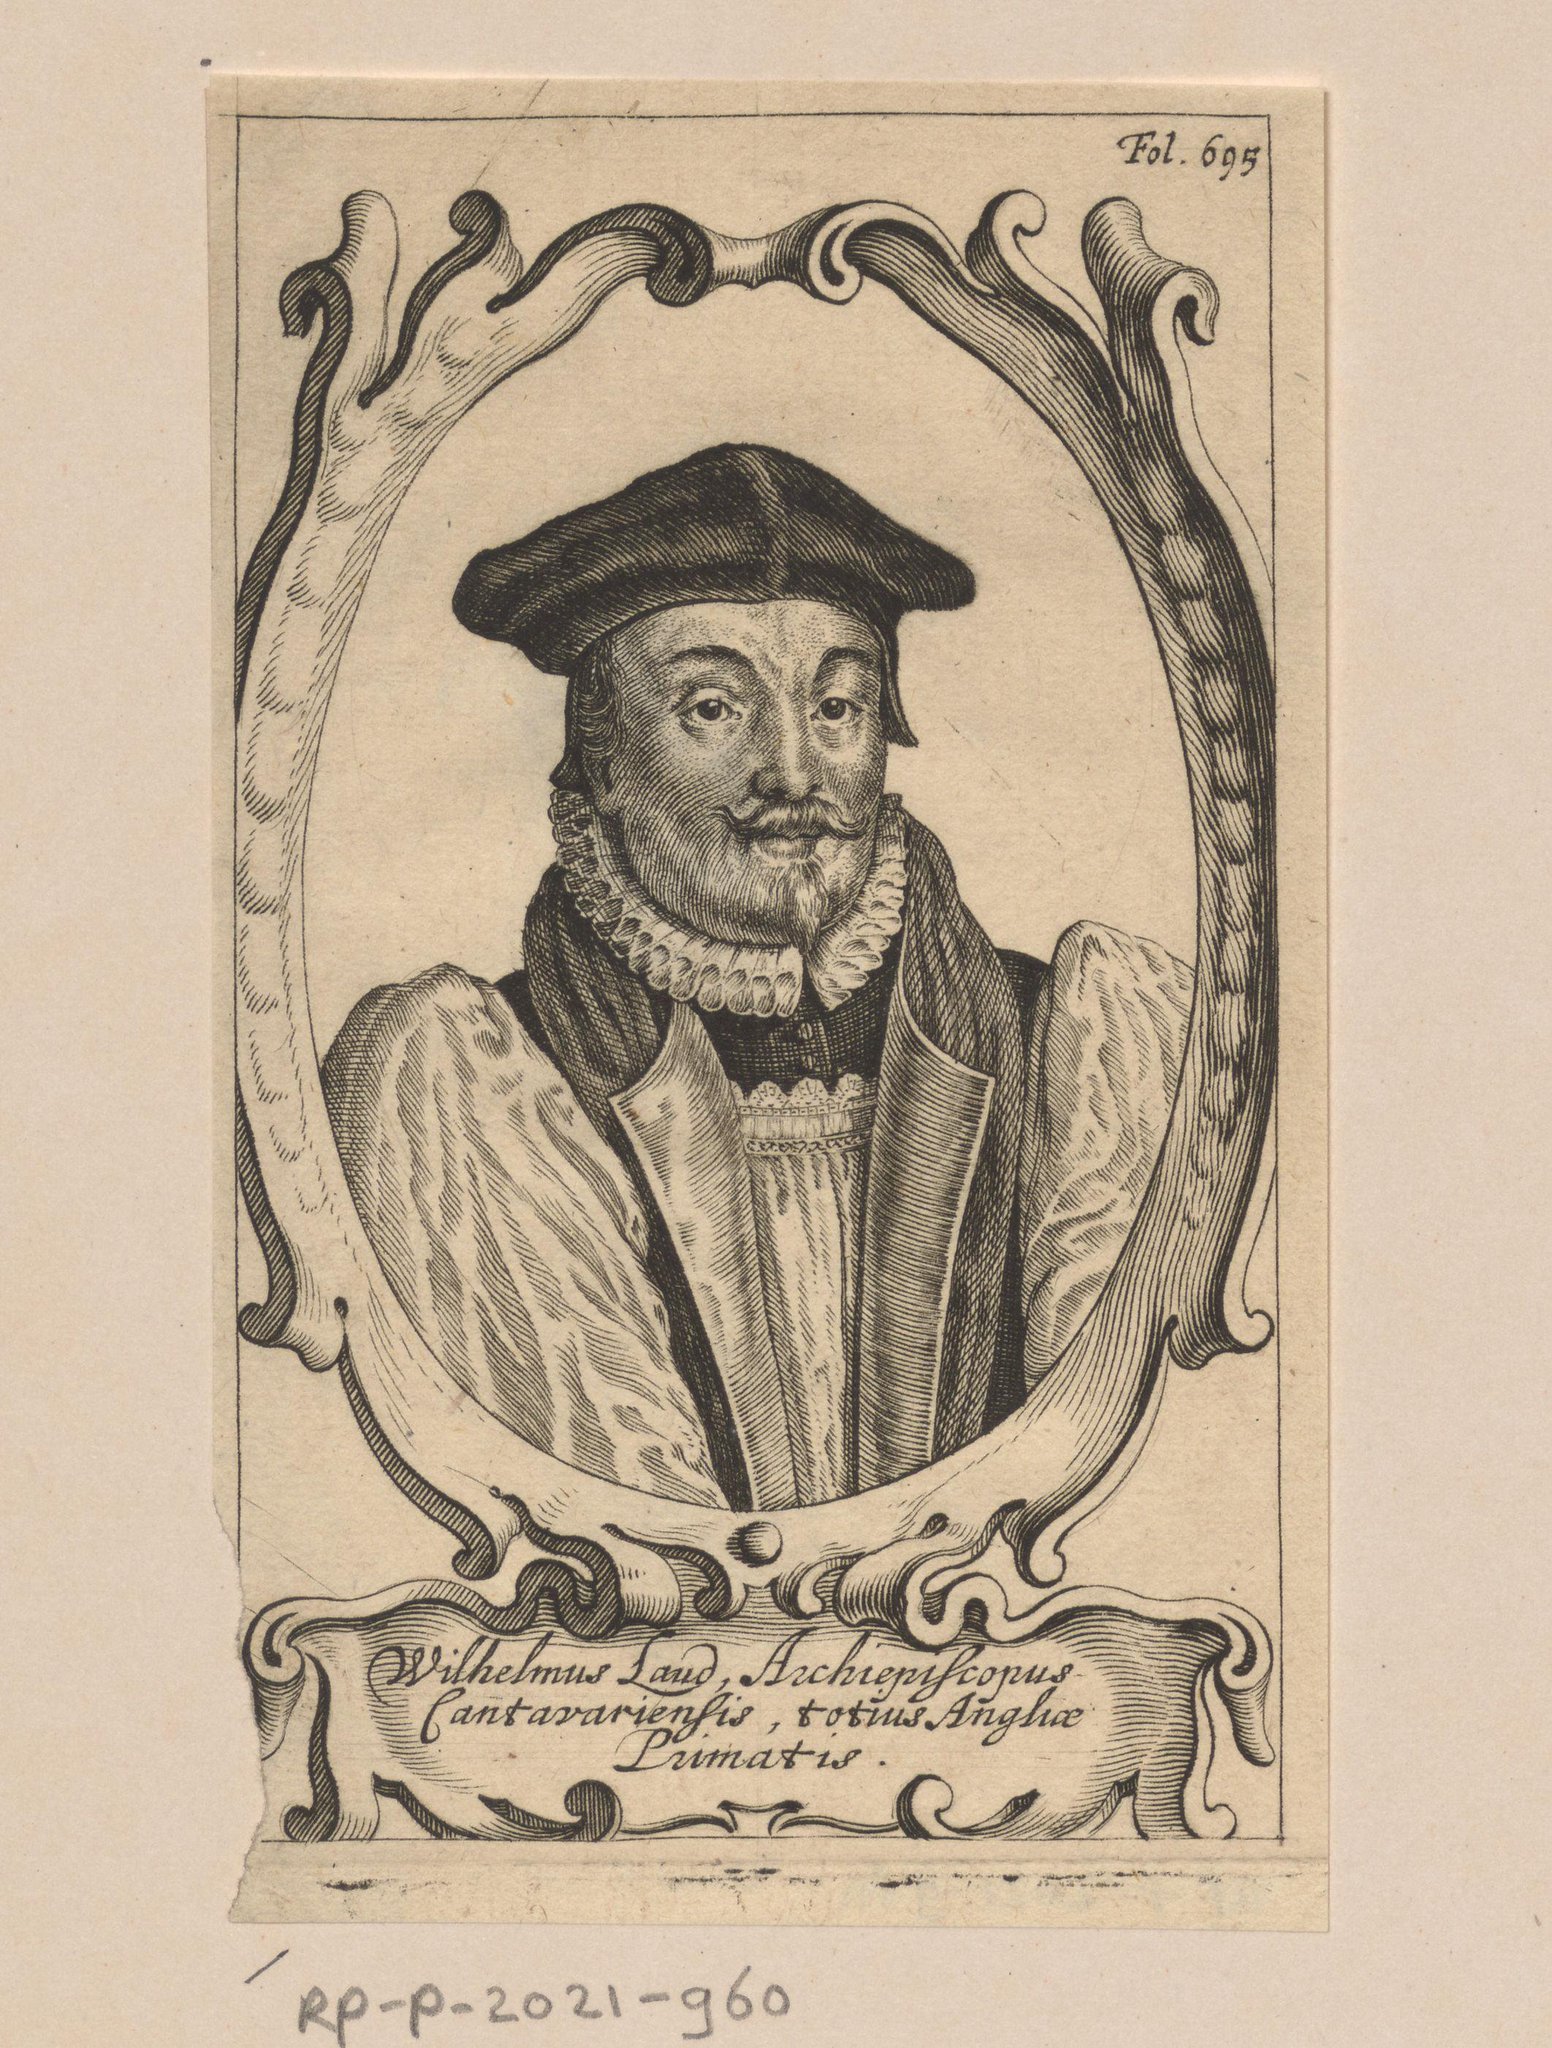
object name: print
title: Portret van William Laud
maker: Anonymous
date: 1656-1666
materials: paper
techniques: engraving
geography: northern netherlands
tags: rocaille ornament, historical persons, ornament ~ cartouche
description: Prent waarschijnlijk uit: Brachelius, Johannes Adolphus. Historia nostri temporis, dat is geschiedenis onses tijts (…). Rotterdam: Andries van Hoogenhuysen, 1656. Prent ook gebruikt in de 1659- en 1666-editie.